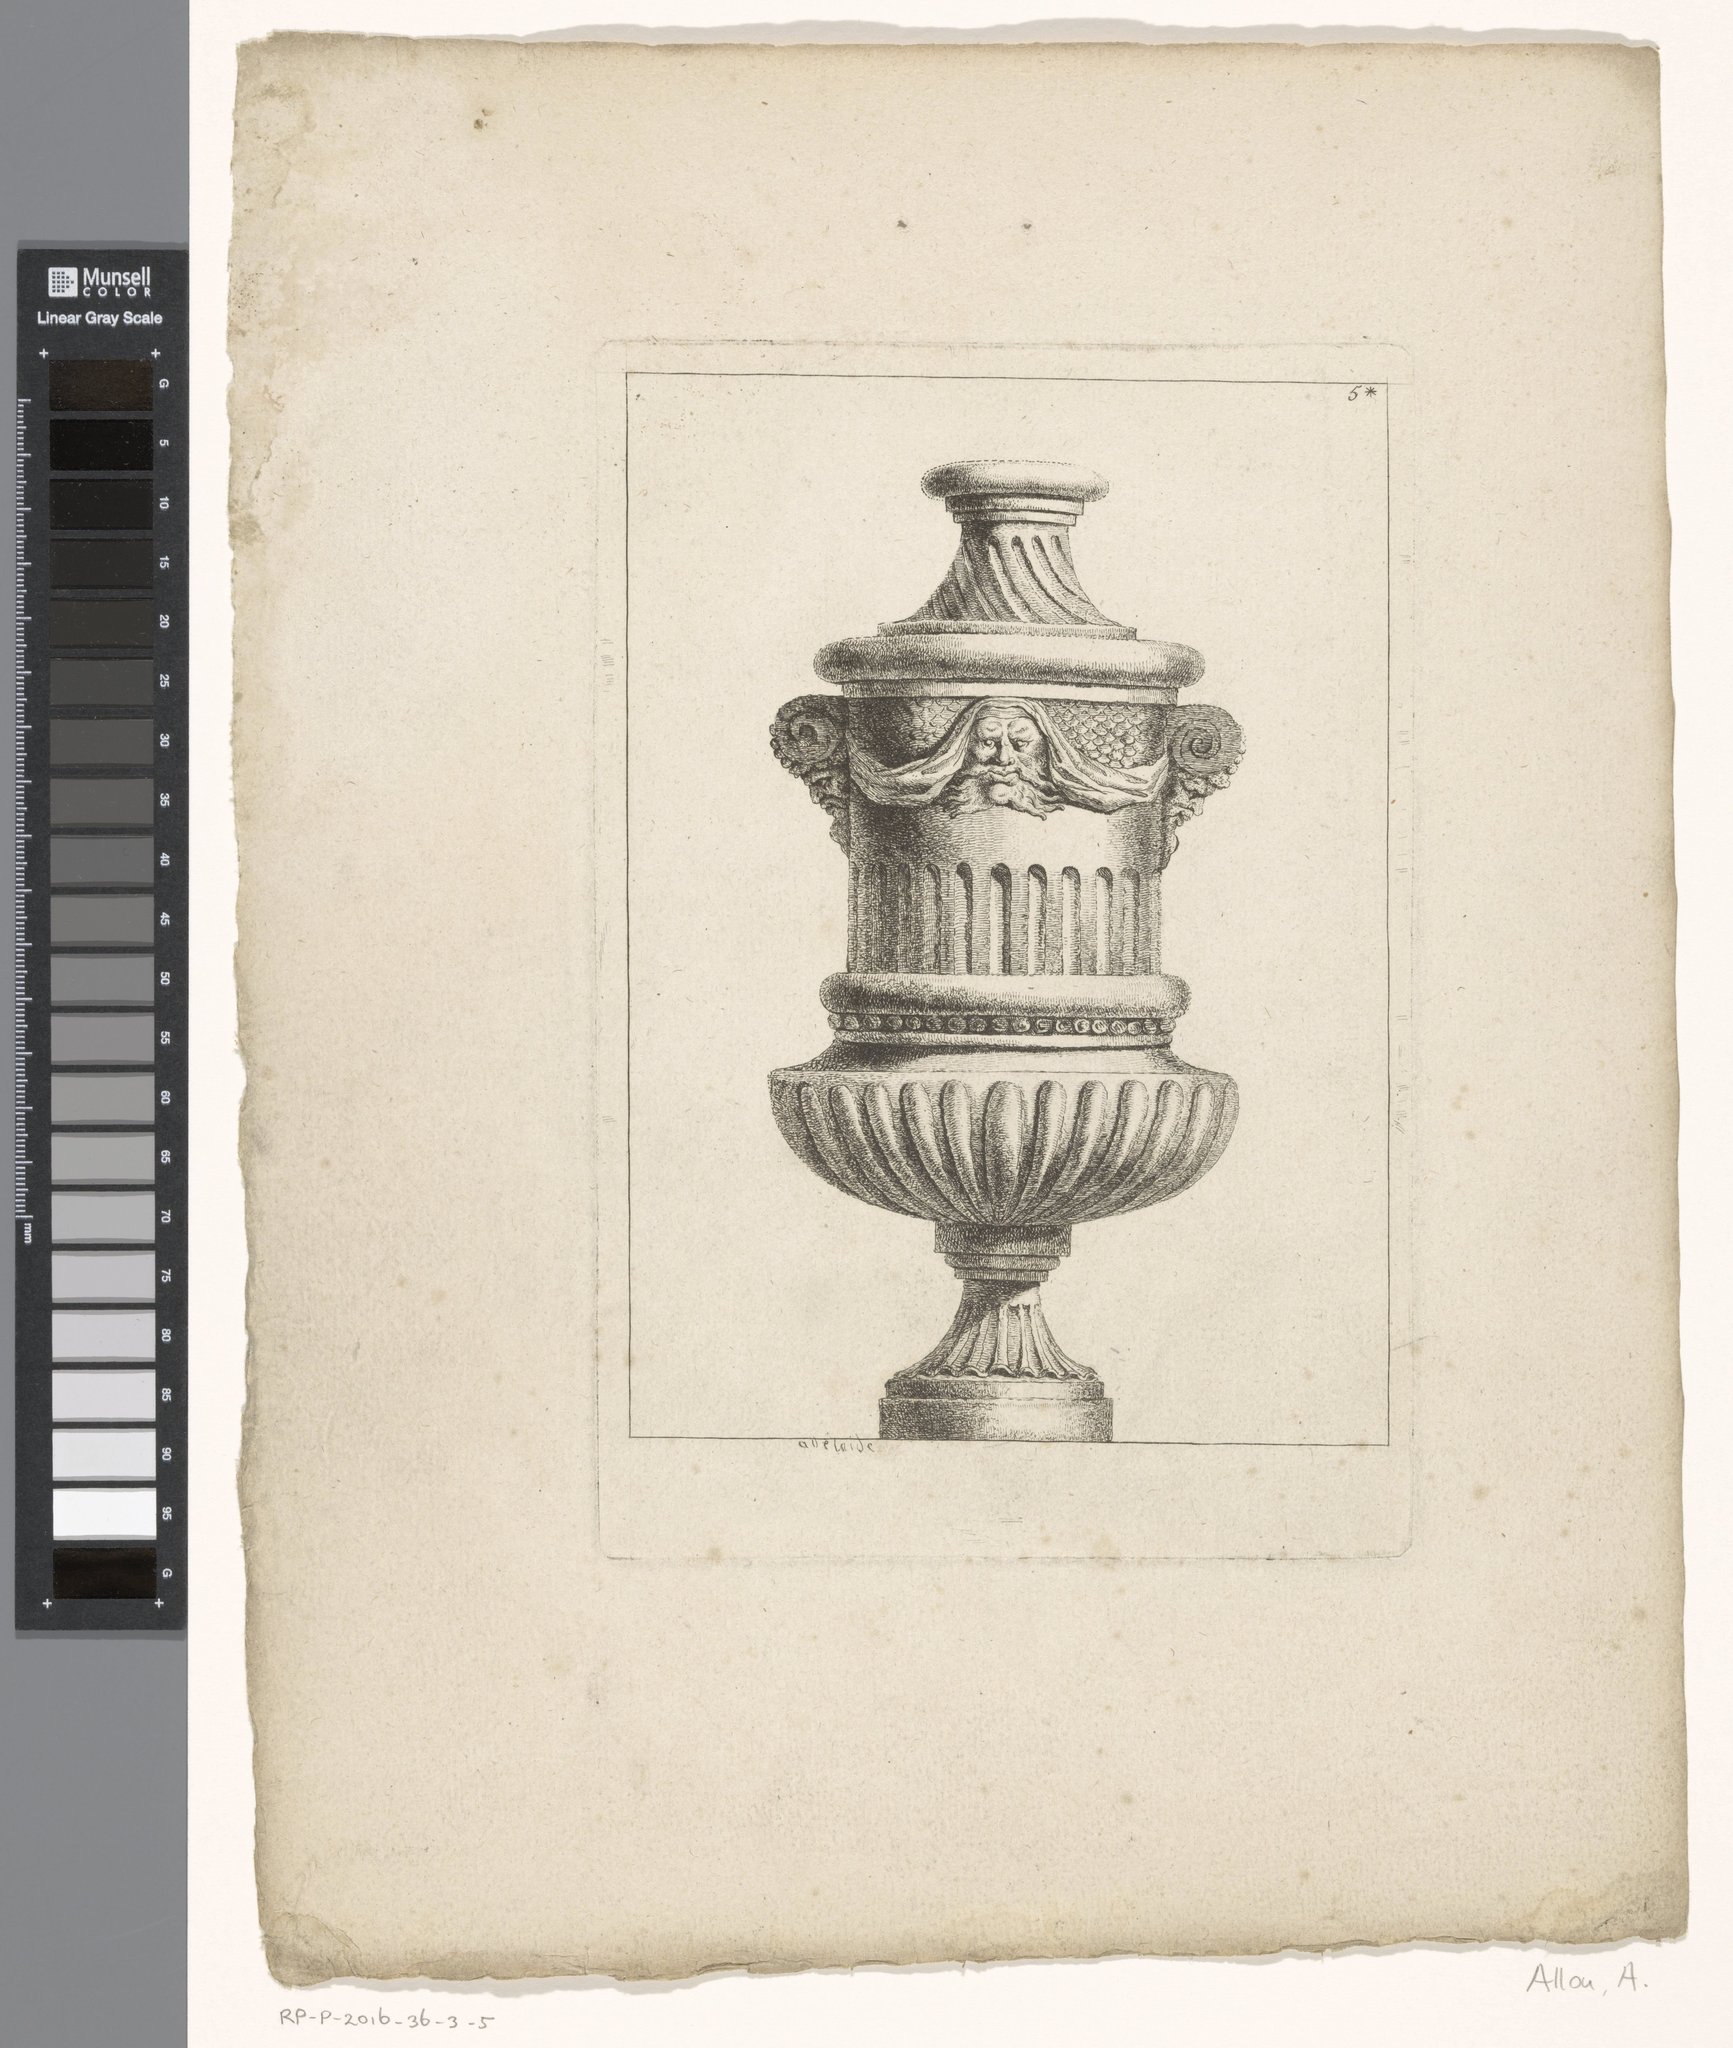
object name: print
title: Vaas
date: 1771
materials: paper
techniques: etching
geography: paris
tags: vase ~ ornament, garden vase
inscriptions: collector's mark: Lugt 2228, collector's mark: Lugt 2760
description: Prent uit een genummerde serie met twaalf vazen door Allou en Nicolet.